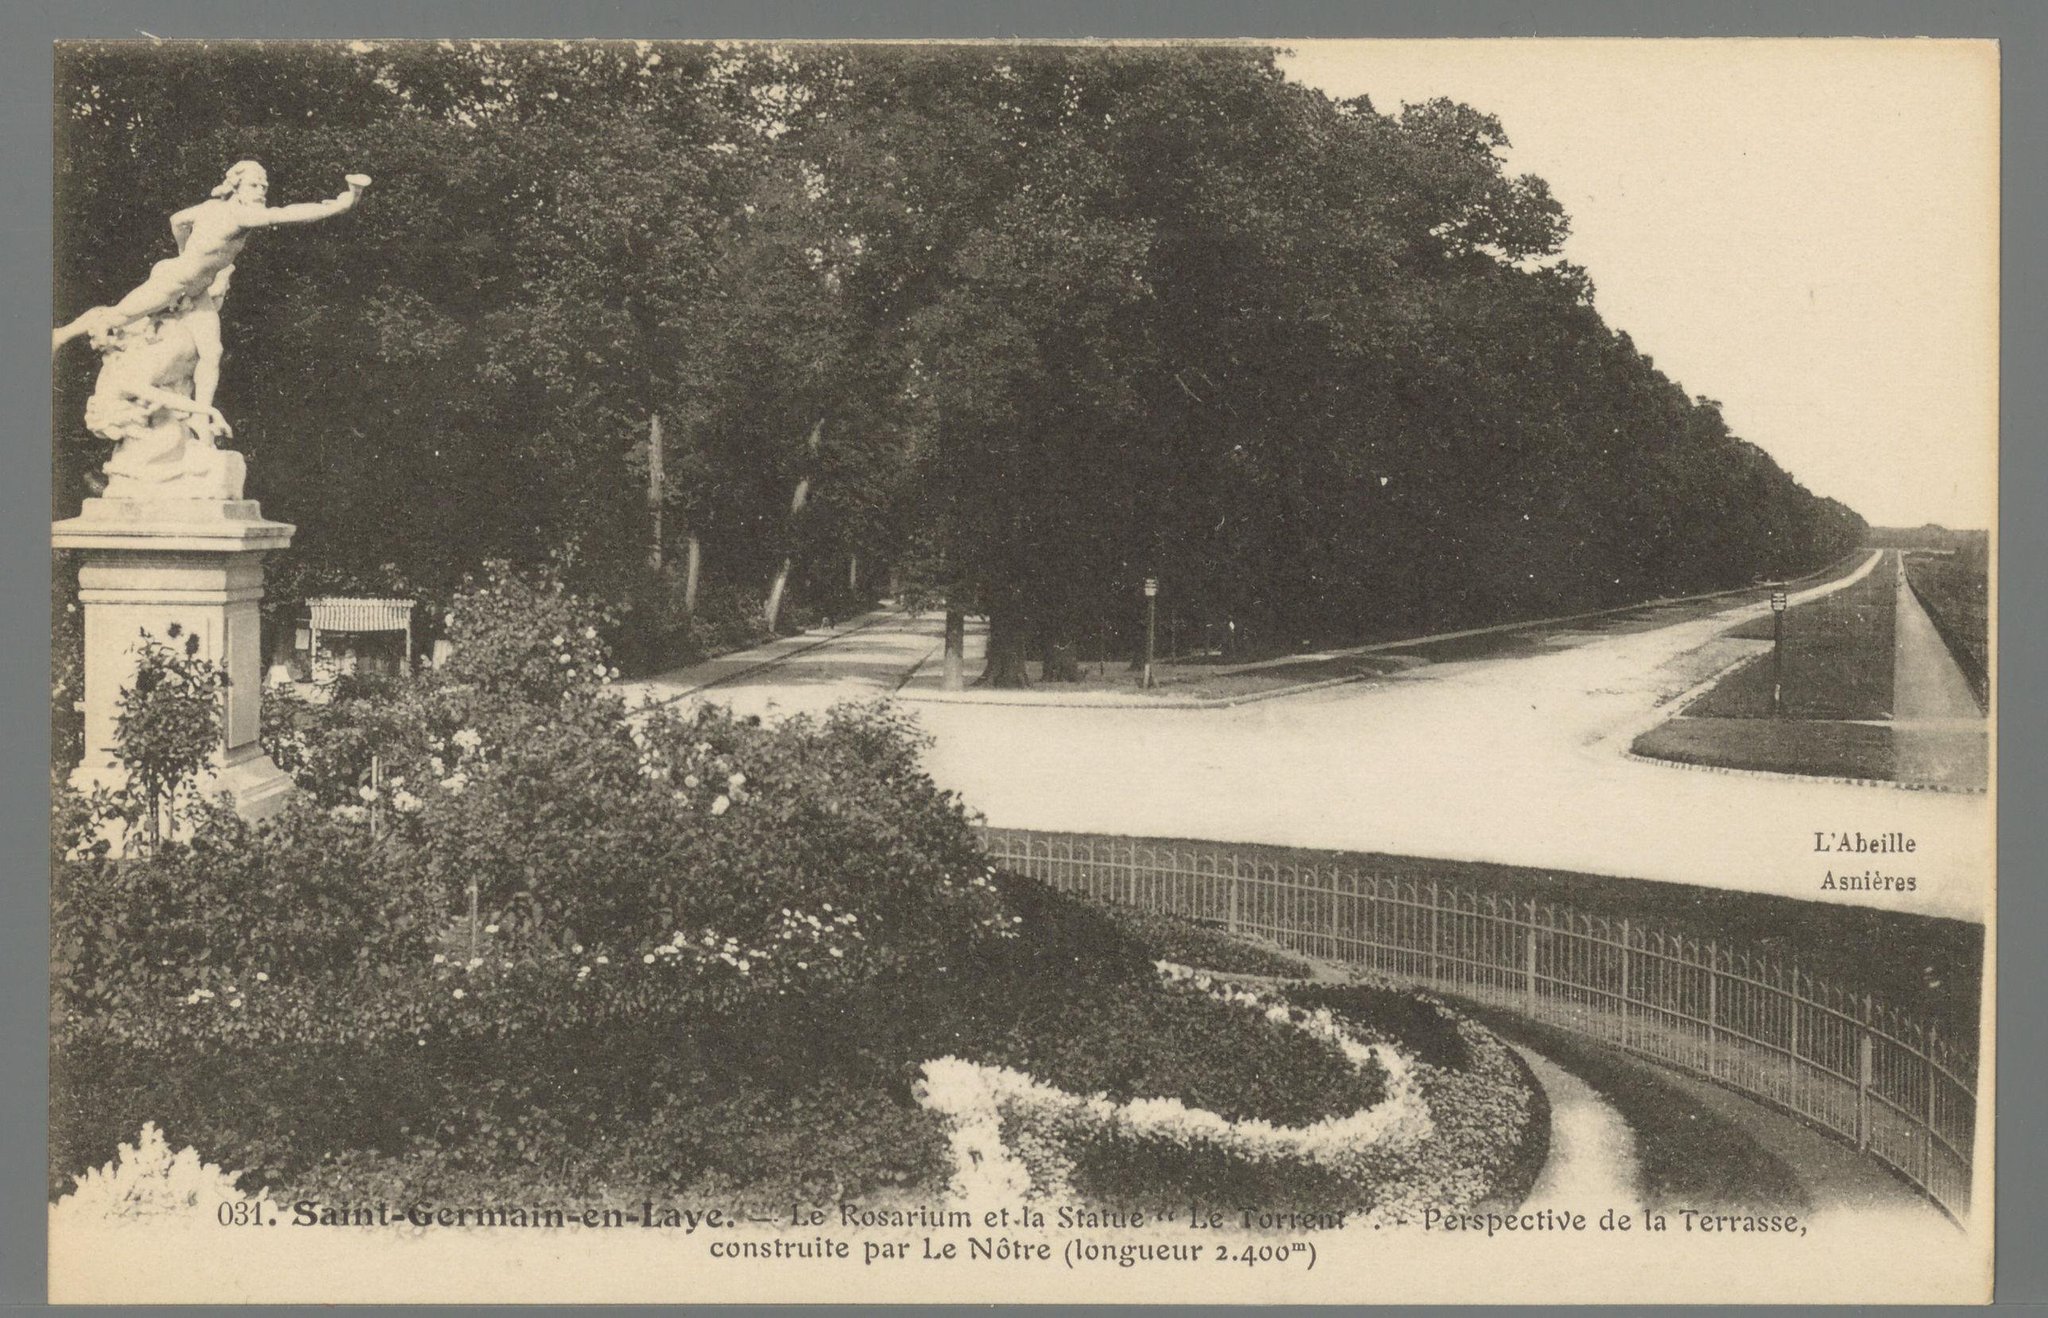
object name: ansichtkaart, prentbriefkaart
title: Saint-Germain-en-Laye. Le Rosarium et la Statue 'Le Torrent'. Perspective de la Terrasse, construite par Le Nôtre (longueur 2.400 m)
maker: Anonymous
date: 1903-1920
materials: cardboard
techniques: photograph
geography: asnières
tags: public gardens, park, statues, sculptures in garden